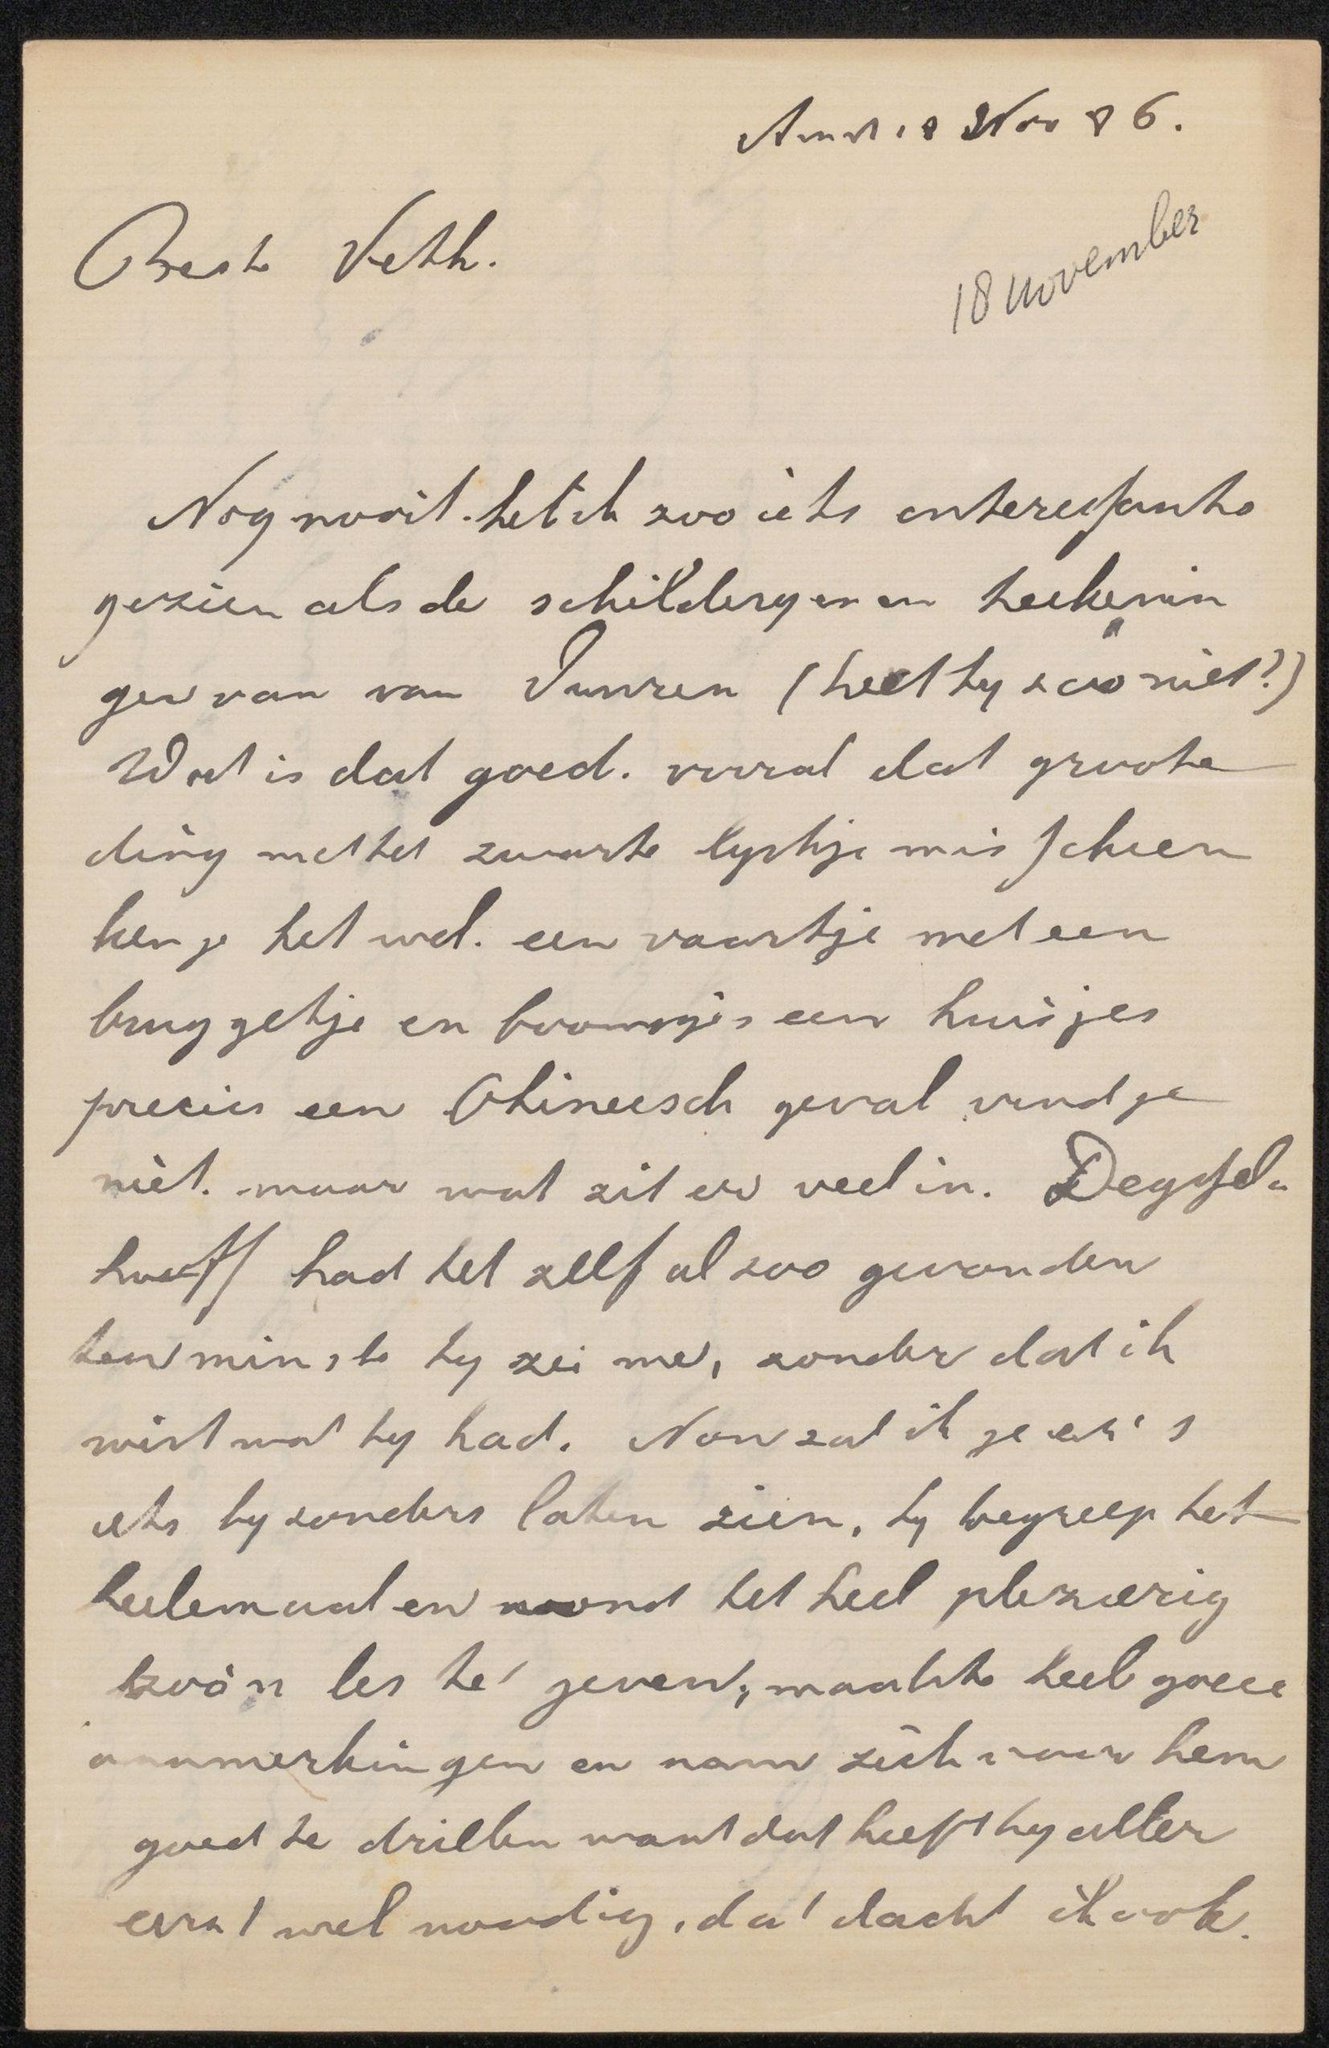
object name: letter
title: Brief aan Jan Veth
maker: maurits van der valk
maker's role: draughtsman, print maker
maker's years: 1857-1935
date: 1886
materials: ink, paper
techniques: pen, writing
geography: amsterdam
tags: the hague, painter, johannes bosboom, dordrecht, designer, jan veth, gerrit willem dijsselhof, criticizing and discussing art, art criticism, drawing, painting (including book-illumination, miniature-painting)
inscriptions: collector's mark: ‘RPK’